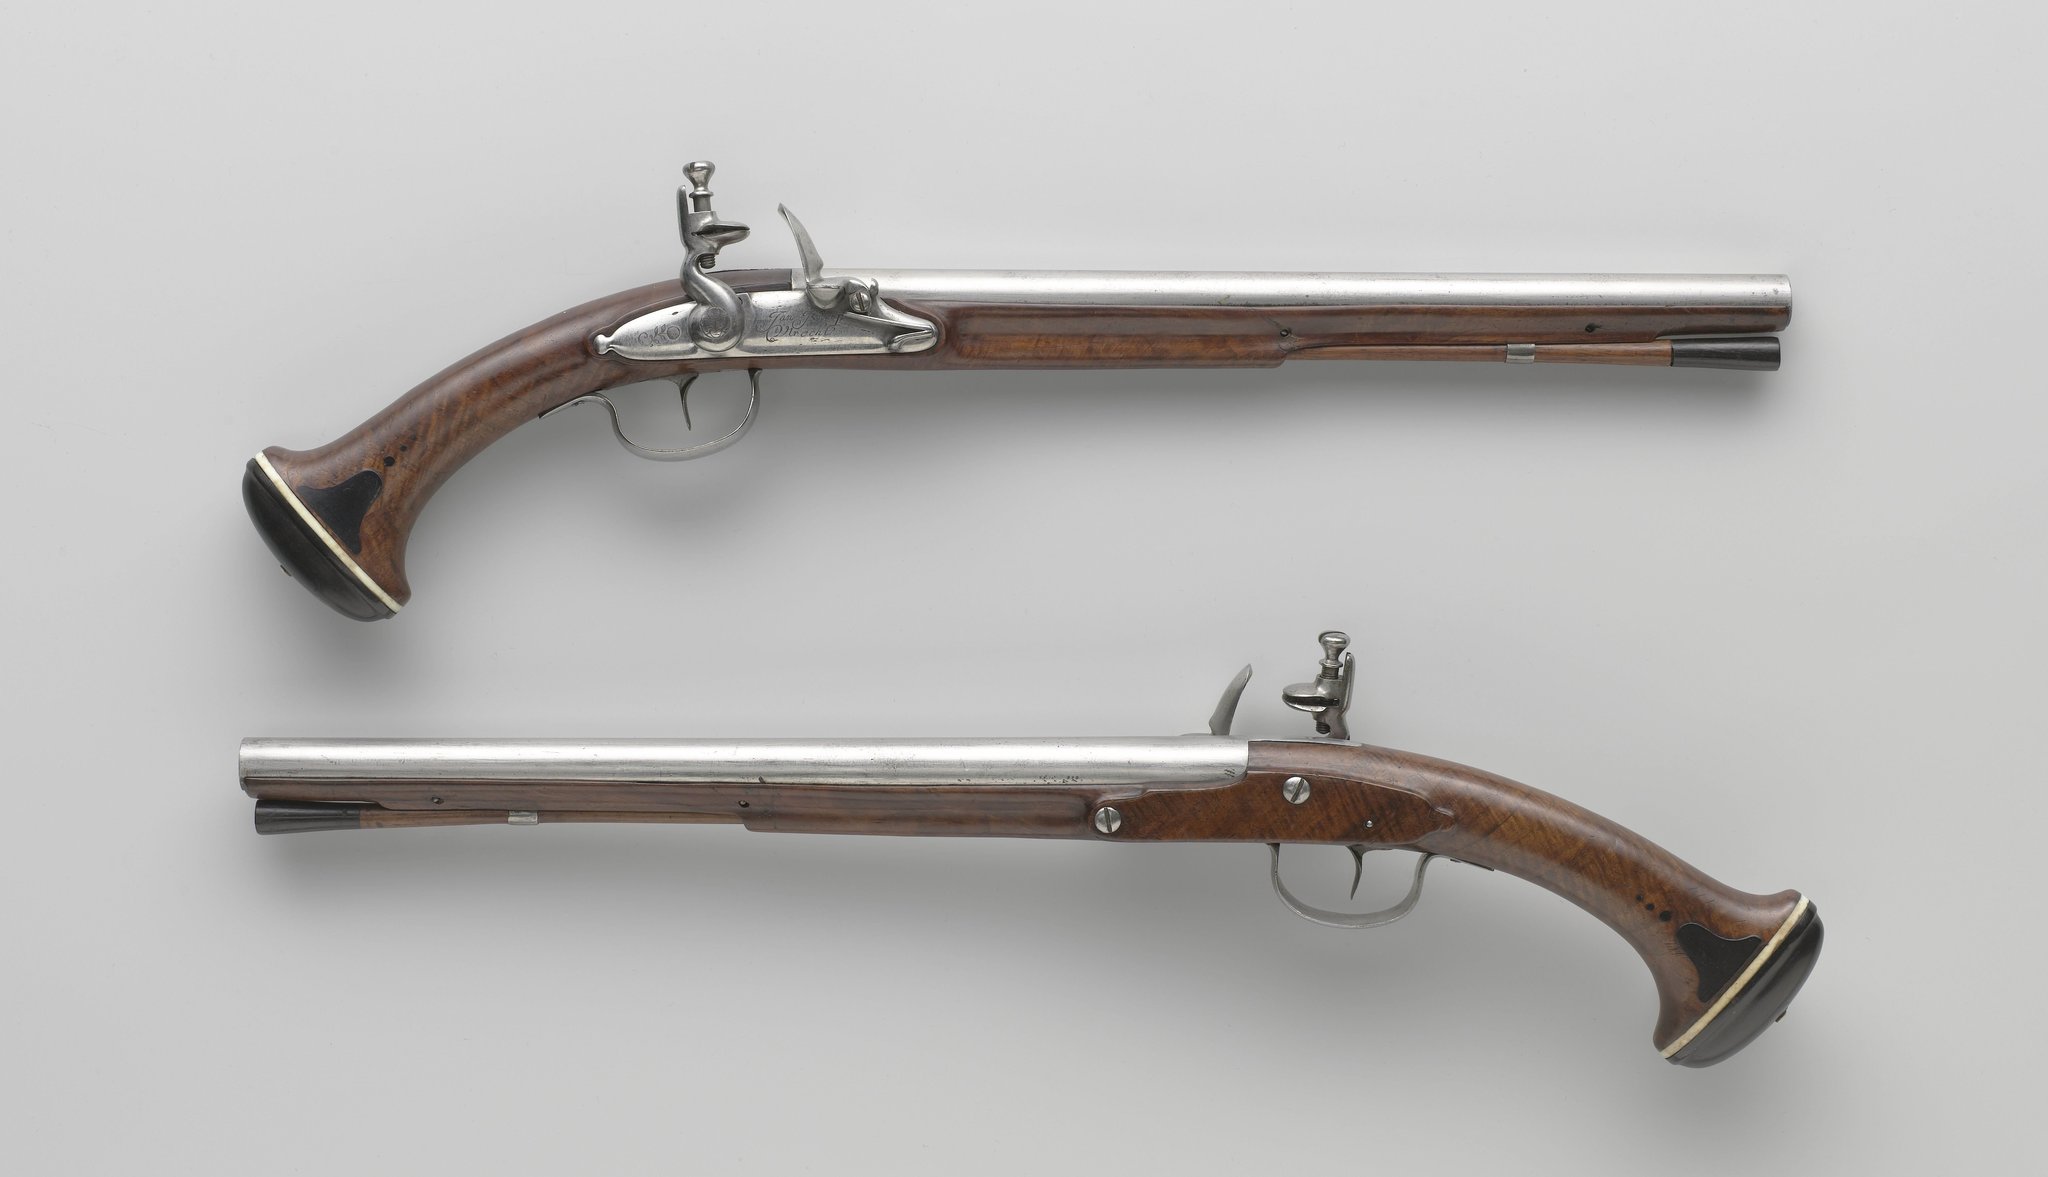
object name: flintlock pistol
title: Vuursteenpistool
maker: jan knoop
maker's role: geweermaker, lademaker, pistoolmaker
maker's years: 1610-1688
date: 1665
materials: wood, iron, ivory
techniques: printing, cutting, engraving, inlay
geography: utrecht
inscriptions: mark, signature: ‘Jan Knoop // tVtrecht’